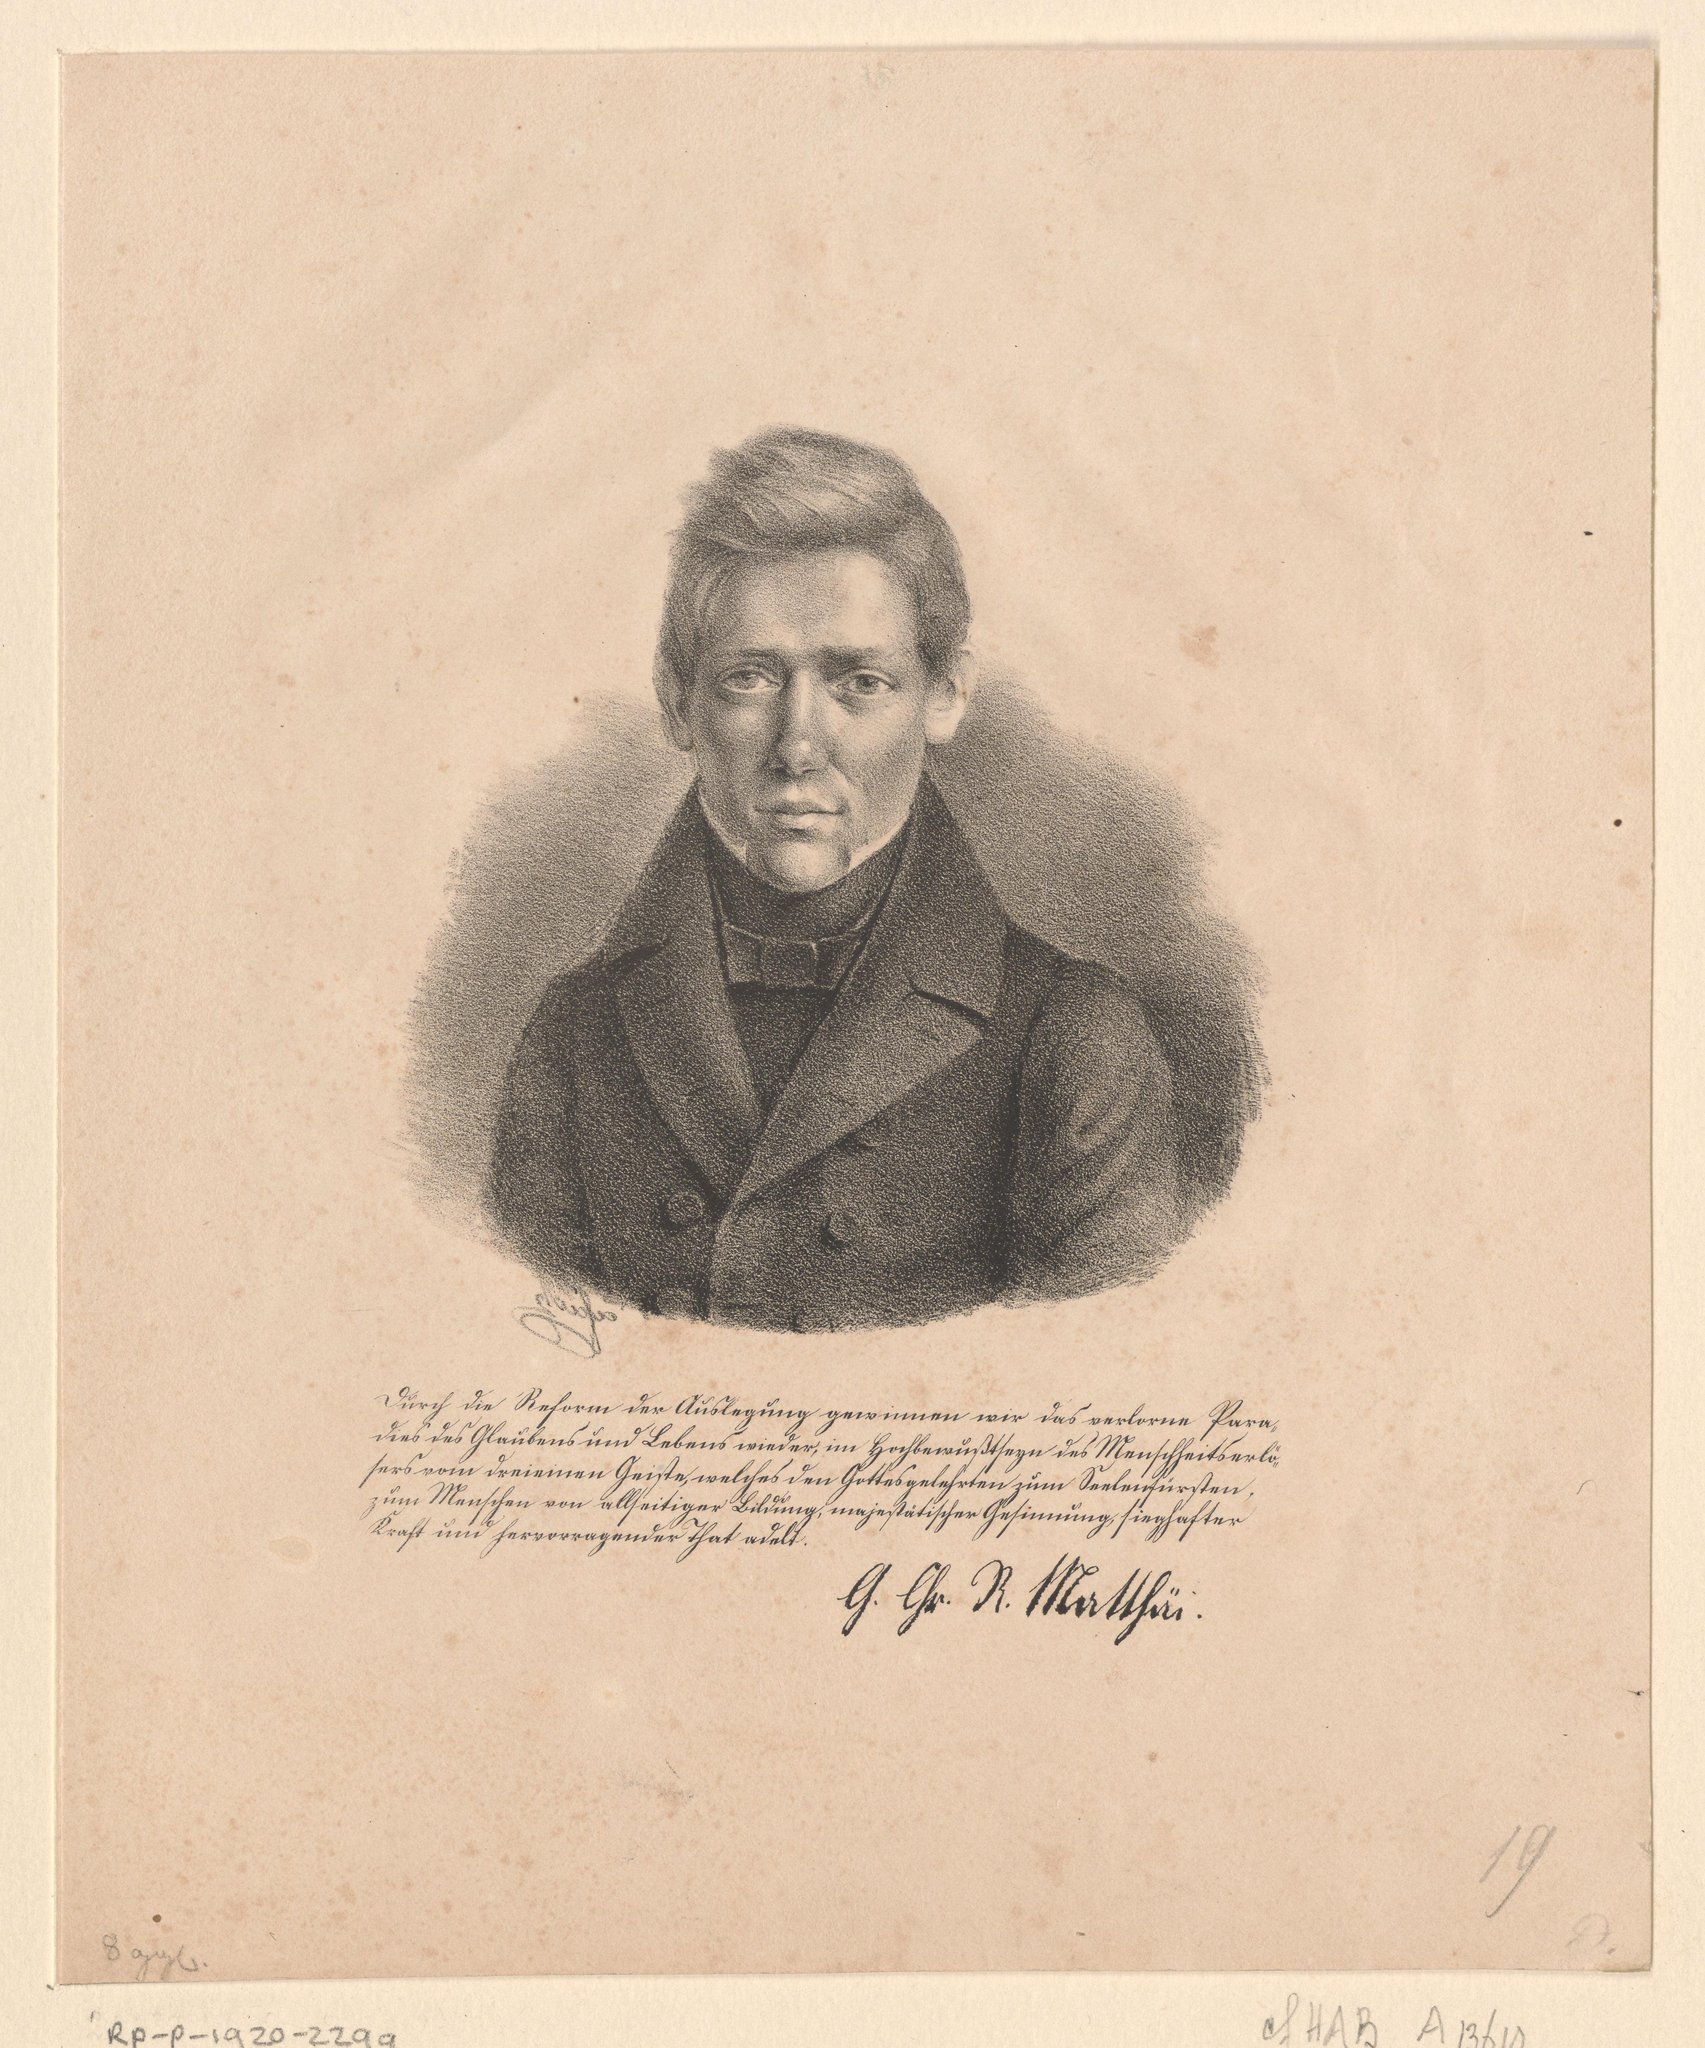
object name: print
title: Portret van Christian Matthei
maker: Anonymous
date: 1834-1899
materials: paper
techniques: lithograph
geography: germany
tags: historical persons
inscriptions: signature: ‘Afach [?]’, collector's mark: Lugt 2228